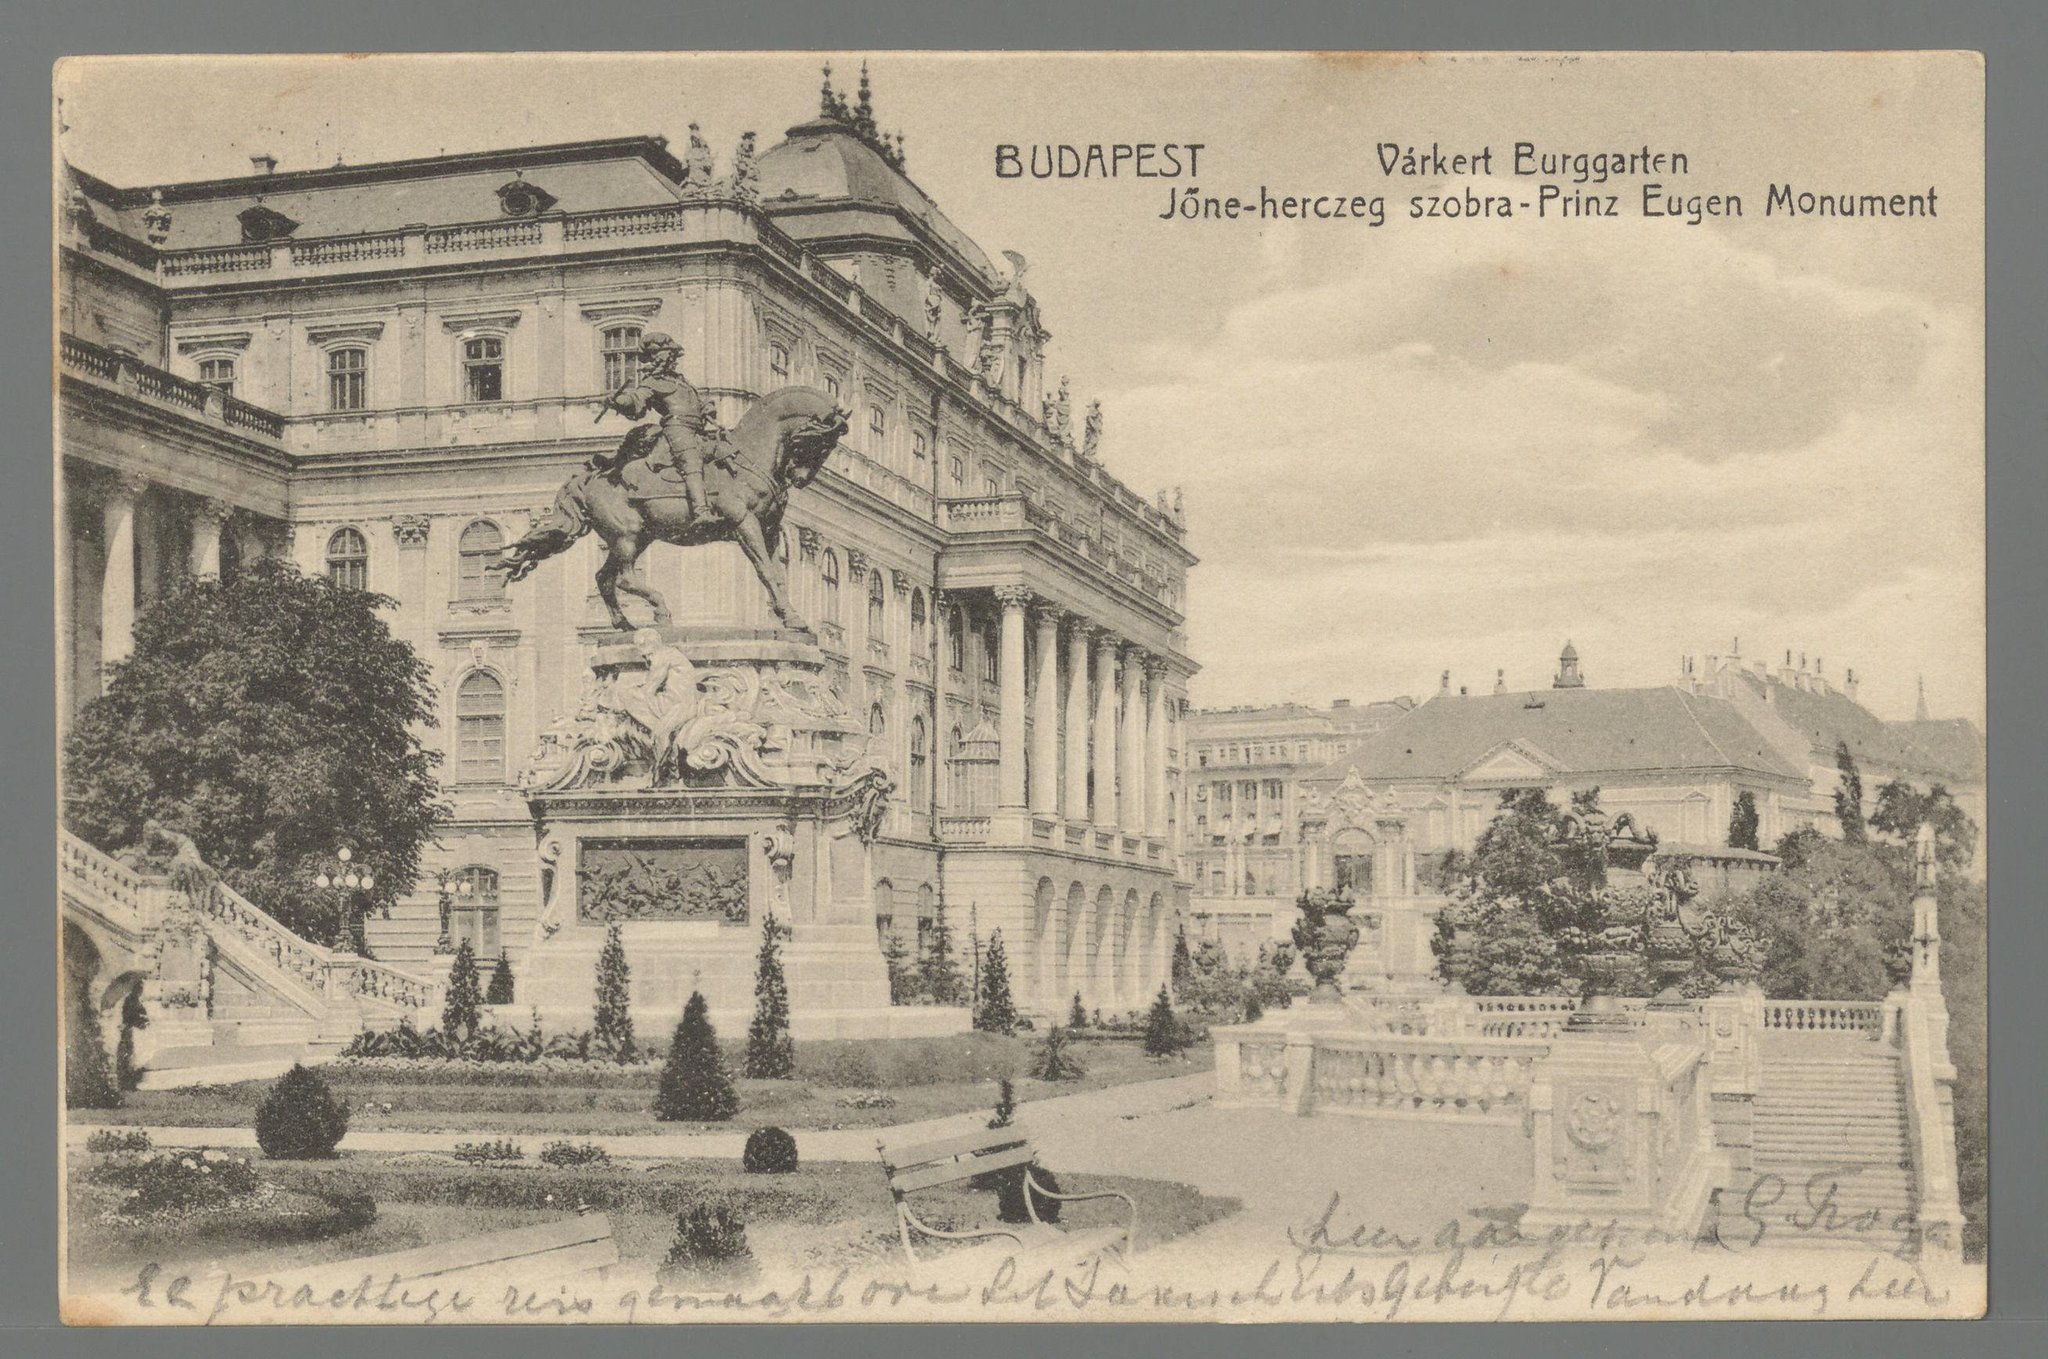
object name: ansichtkaart, prentbriefkaart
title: Budapest Várkert Burggarten Jone-herczeg szobra-Prinz Eugen Monument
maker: Anonymous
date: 1900-1905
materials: cardboard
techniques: photograph, writing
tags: monument, statue, façade (of house or building)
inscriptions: postage stamp